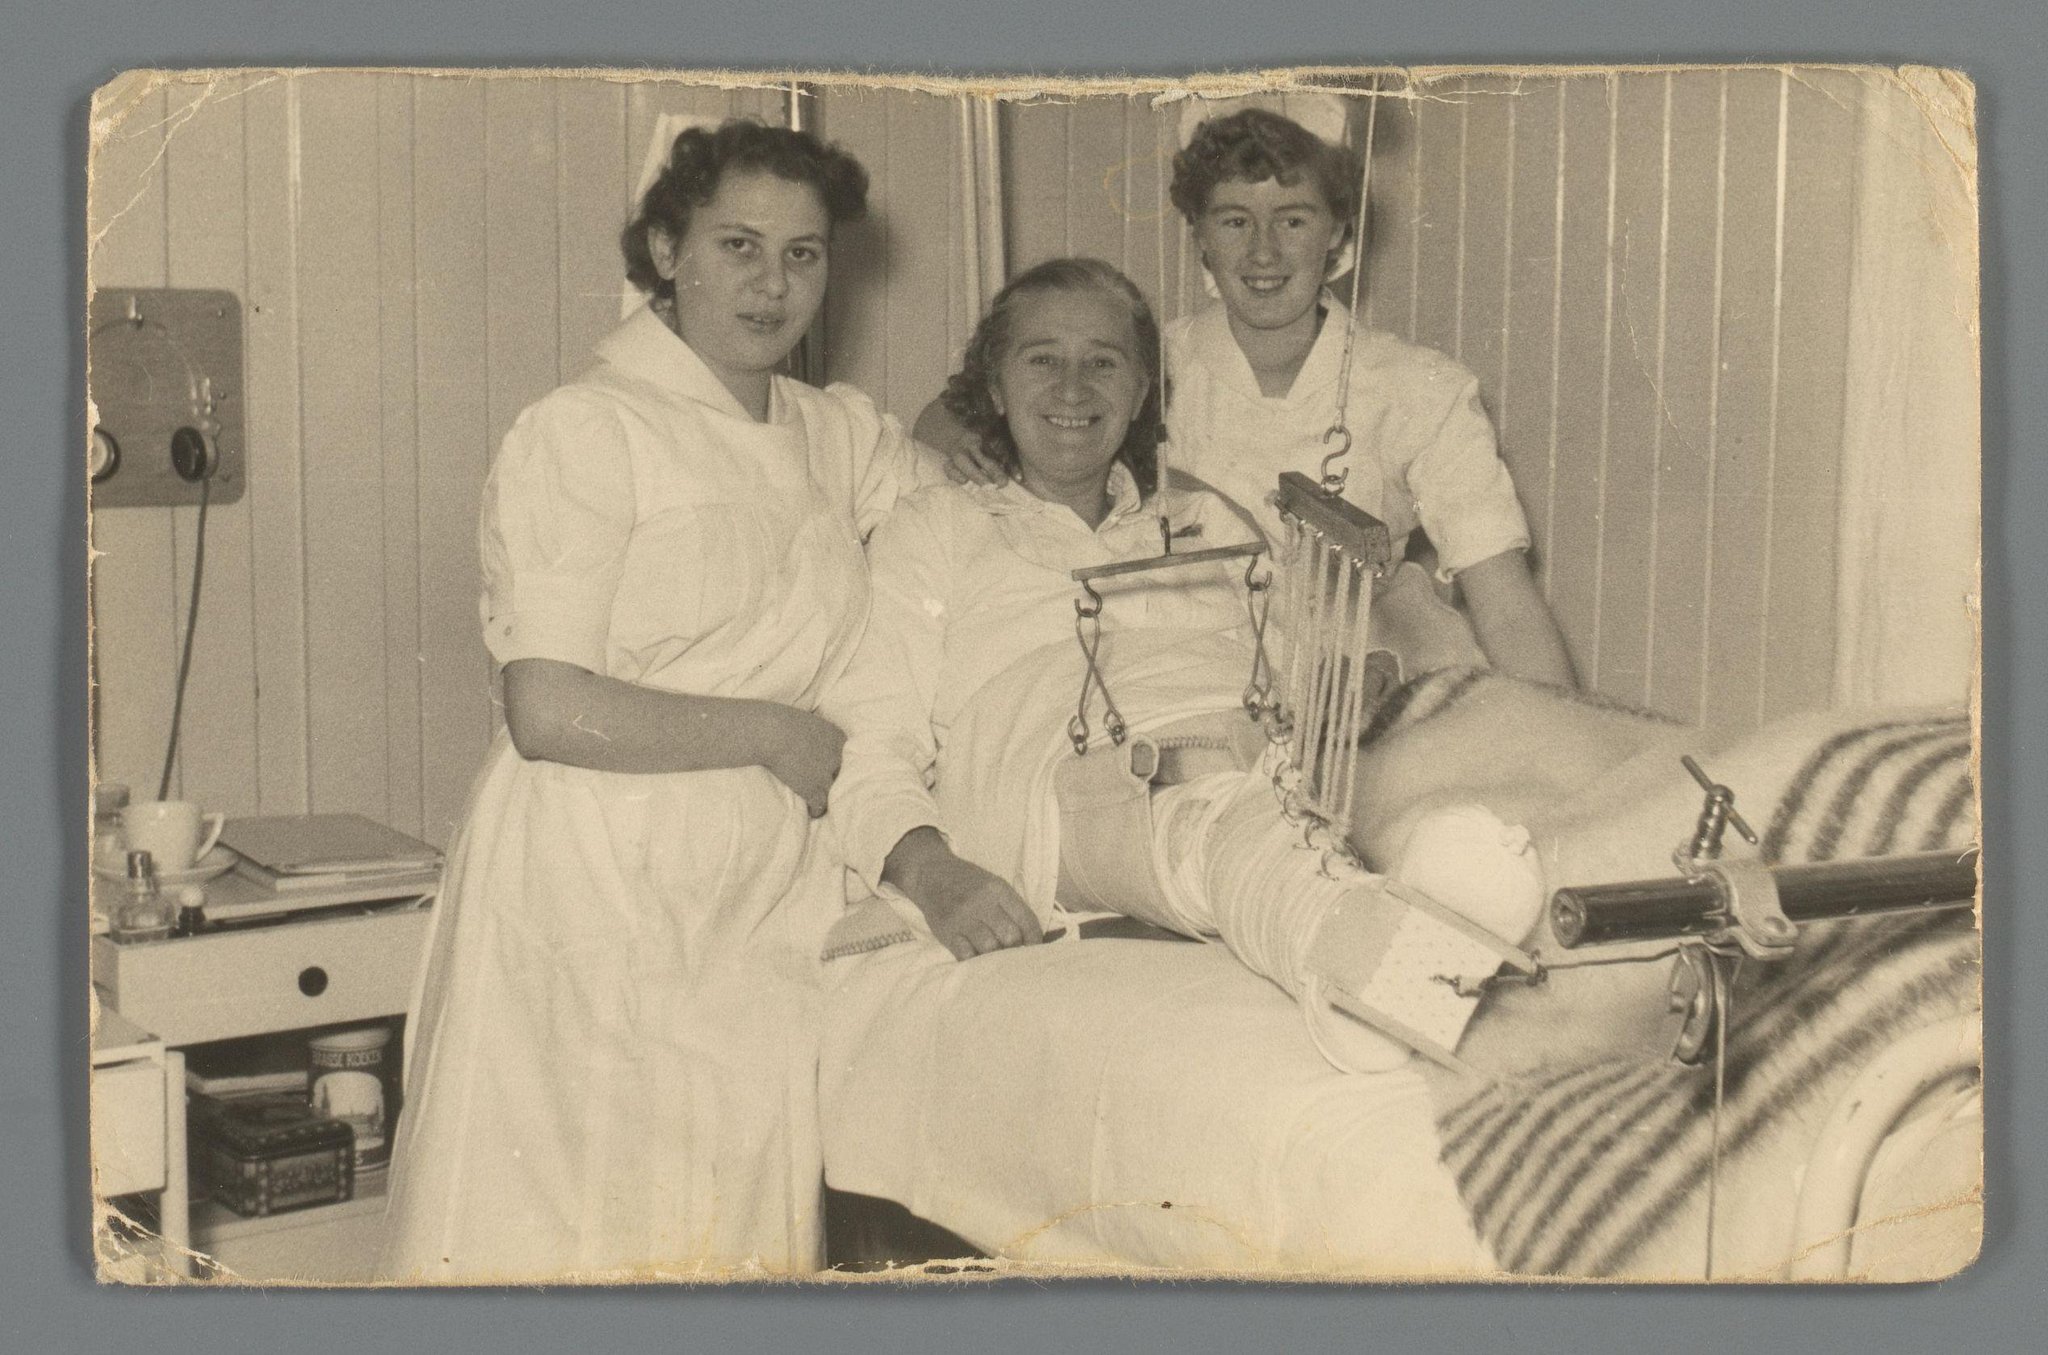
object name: photograph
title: Portret van Cato Merks met haar been in het gips, samen met twee onbekende verpleegsters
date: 1950-1970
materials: paper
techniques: gelatin silver print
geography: amsterdam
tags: historical persons - bb - woman, nurse ~ hospital, treatment by immobilization, sling, splint, plaster, etc., visiting the sick; sick person together with others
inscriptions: number: ‘32’, inscription: ‘Cato Merks’, stamp: ‘Copyright by/ Foto-Film-Bureau/ "Home Service"/ Amsterdam-O./ Hugo de Vrieslaan 139 (...) G. 703.’